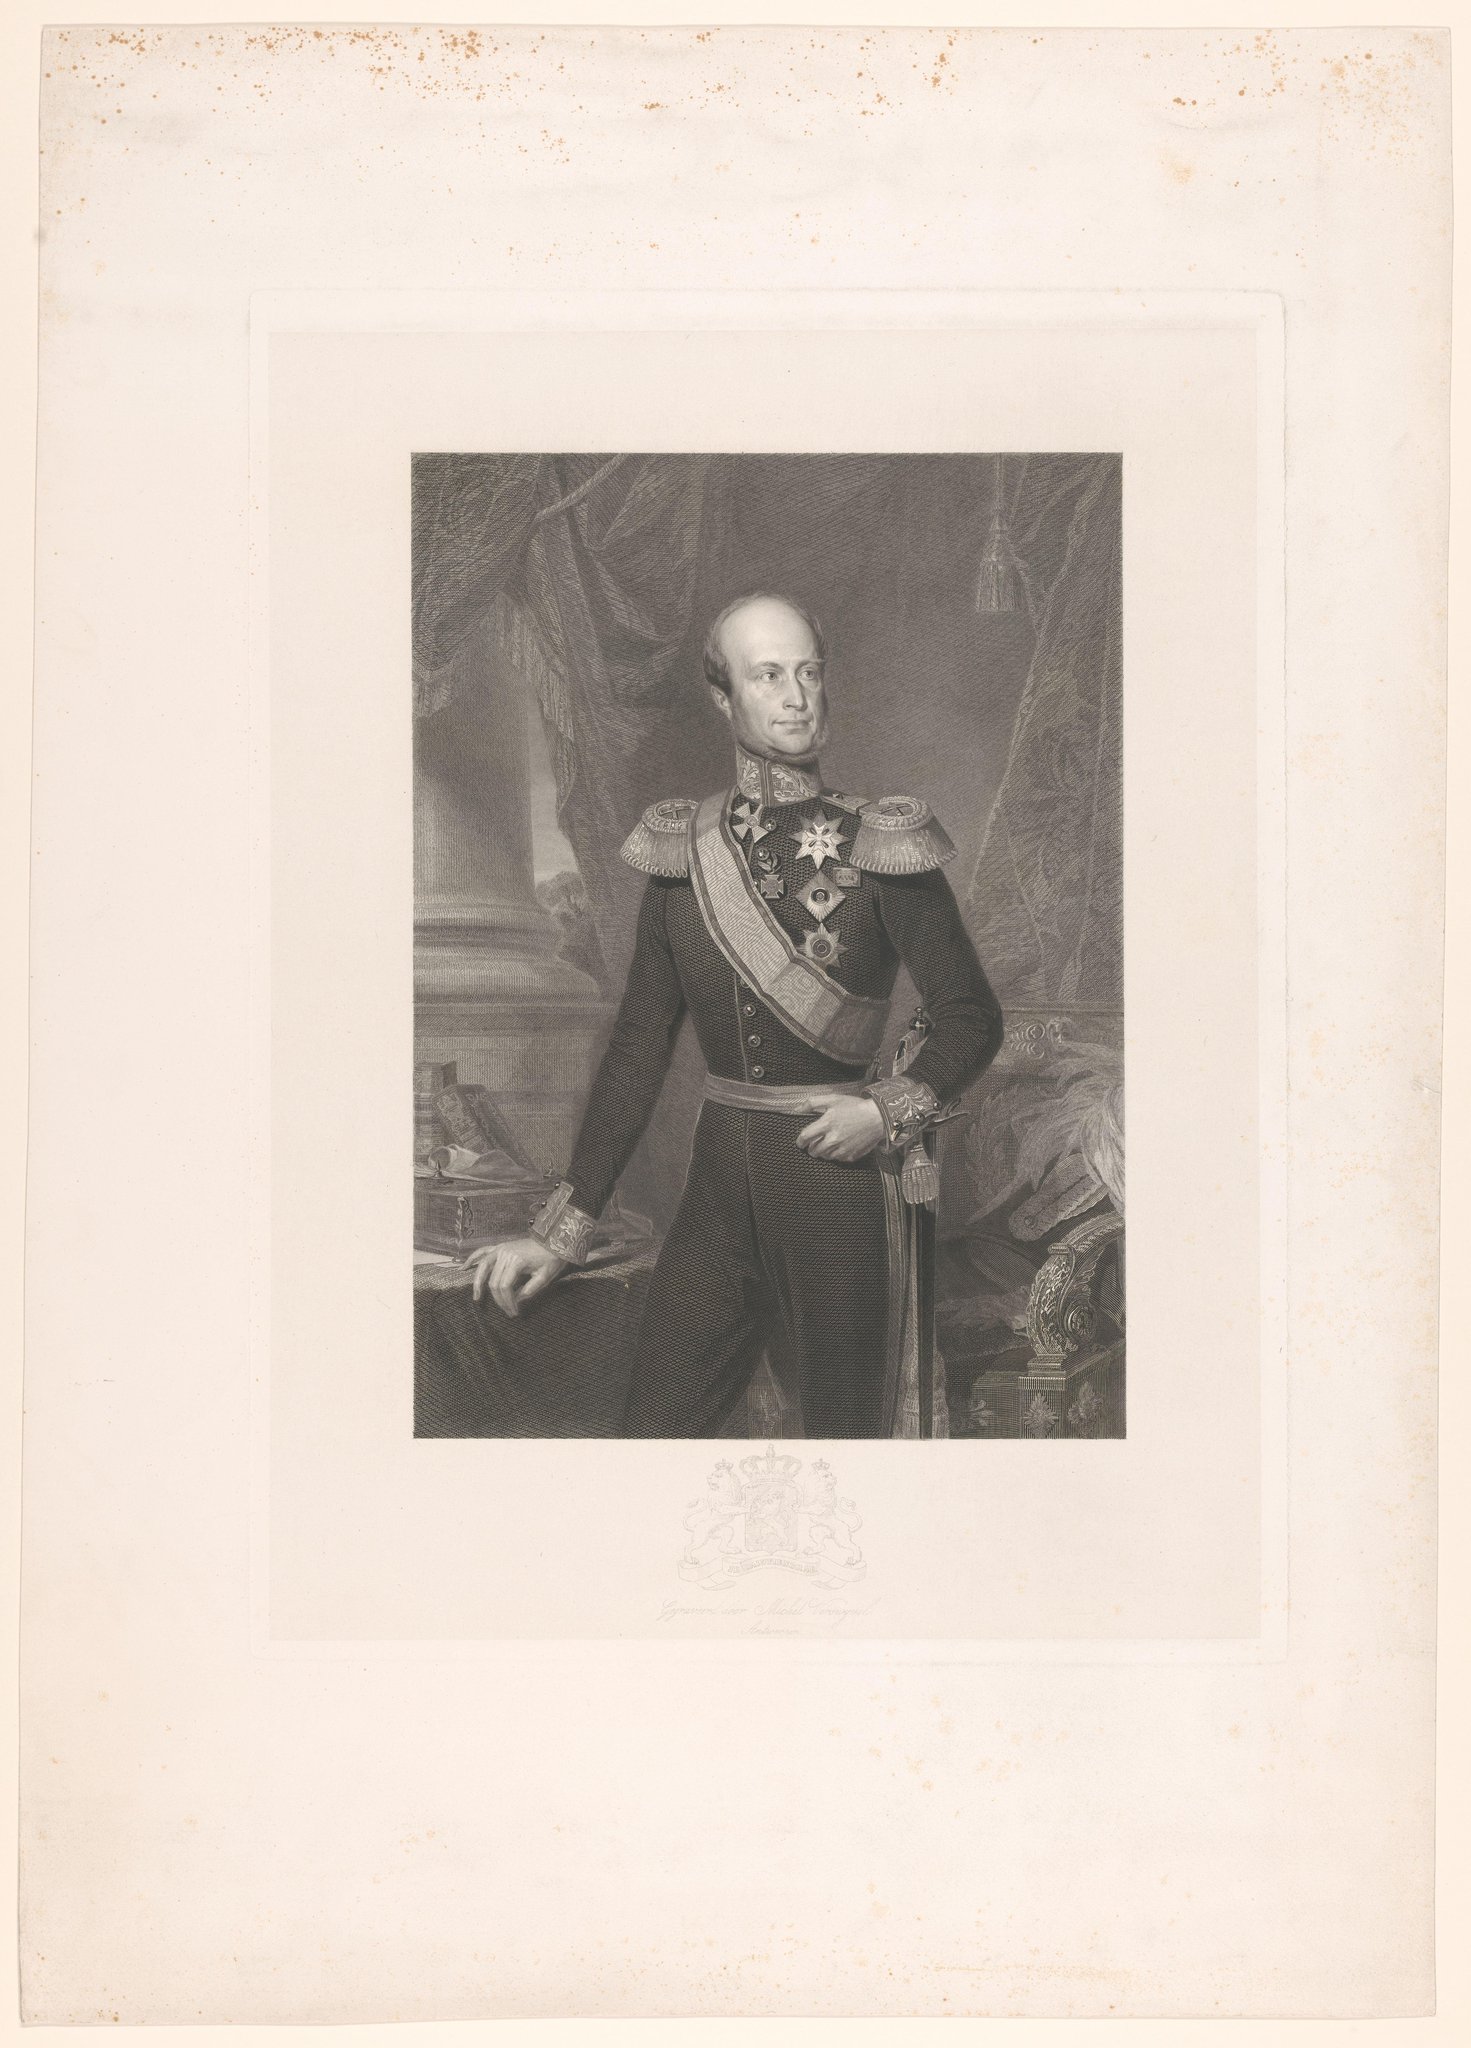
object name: print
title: Portret van Koning Willem II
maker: michel charles antoine verswyvel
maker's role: print maker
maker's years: 1819-1868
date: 1829-1868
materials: paper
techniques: engraving, etching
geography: antwerp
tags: the hague, william ii of the netherlands, historical persons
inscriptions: collector's mark: Lugt 2228